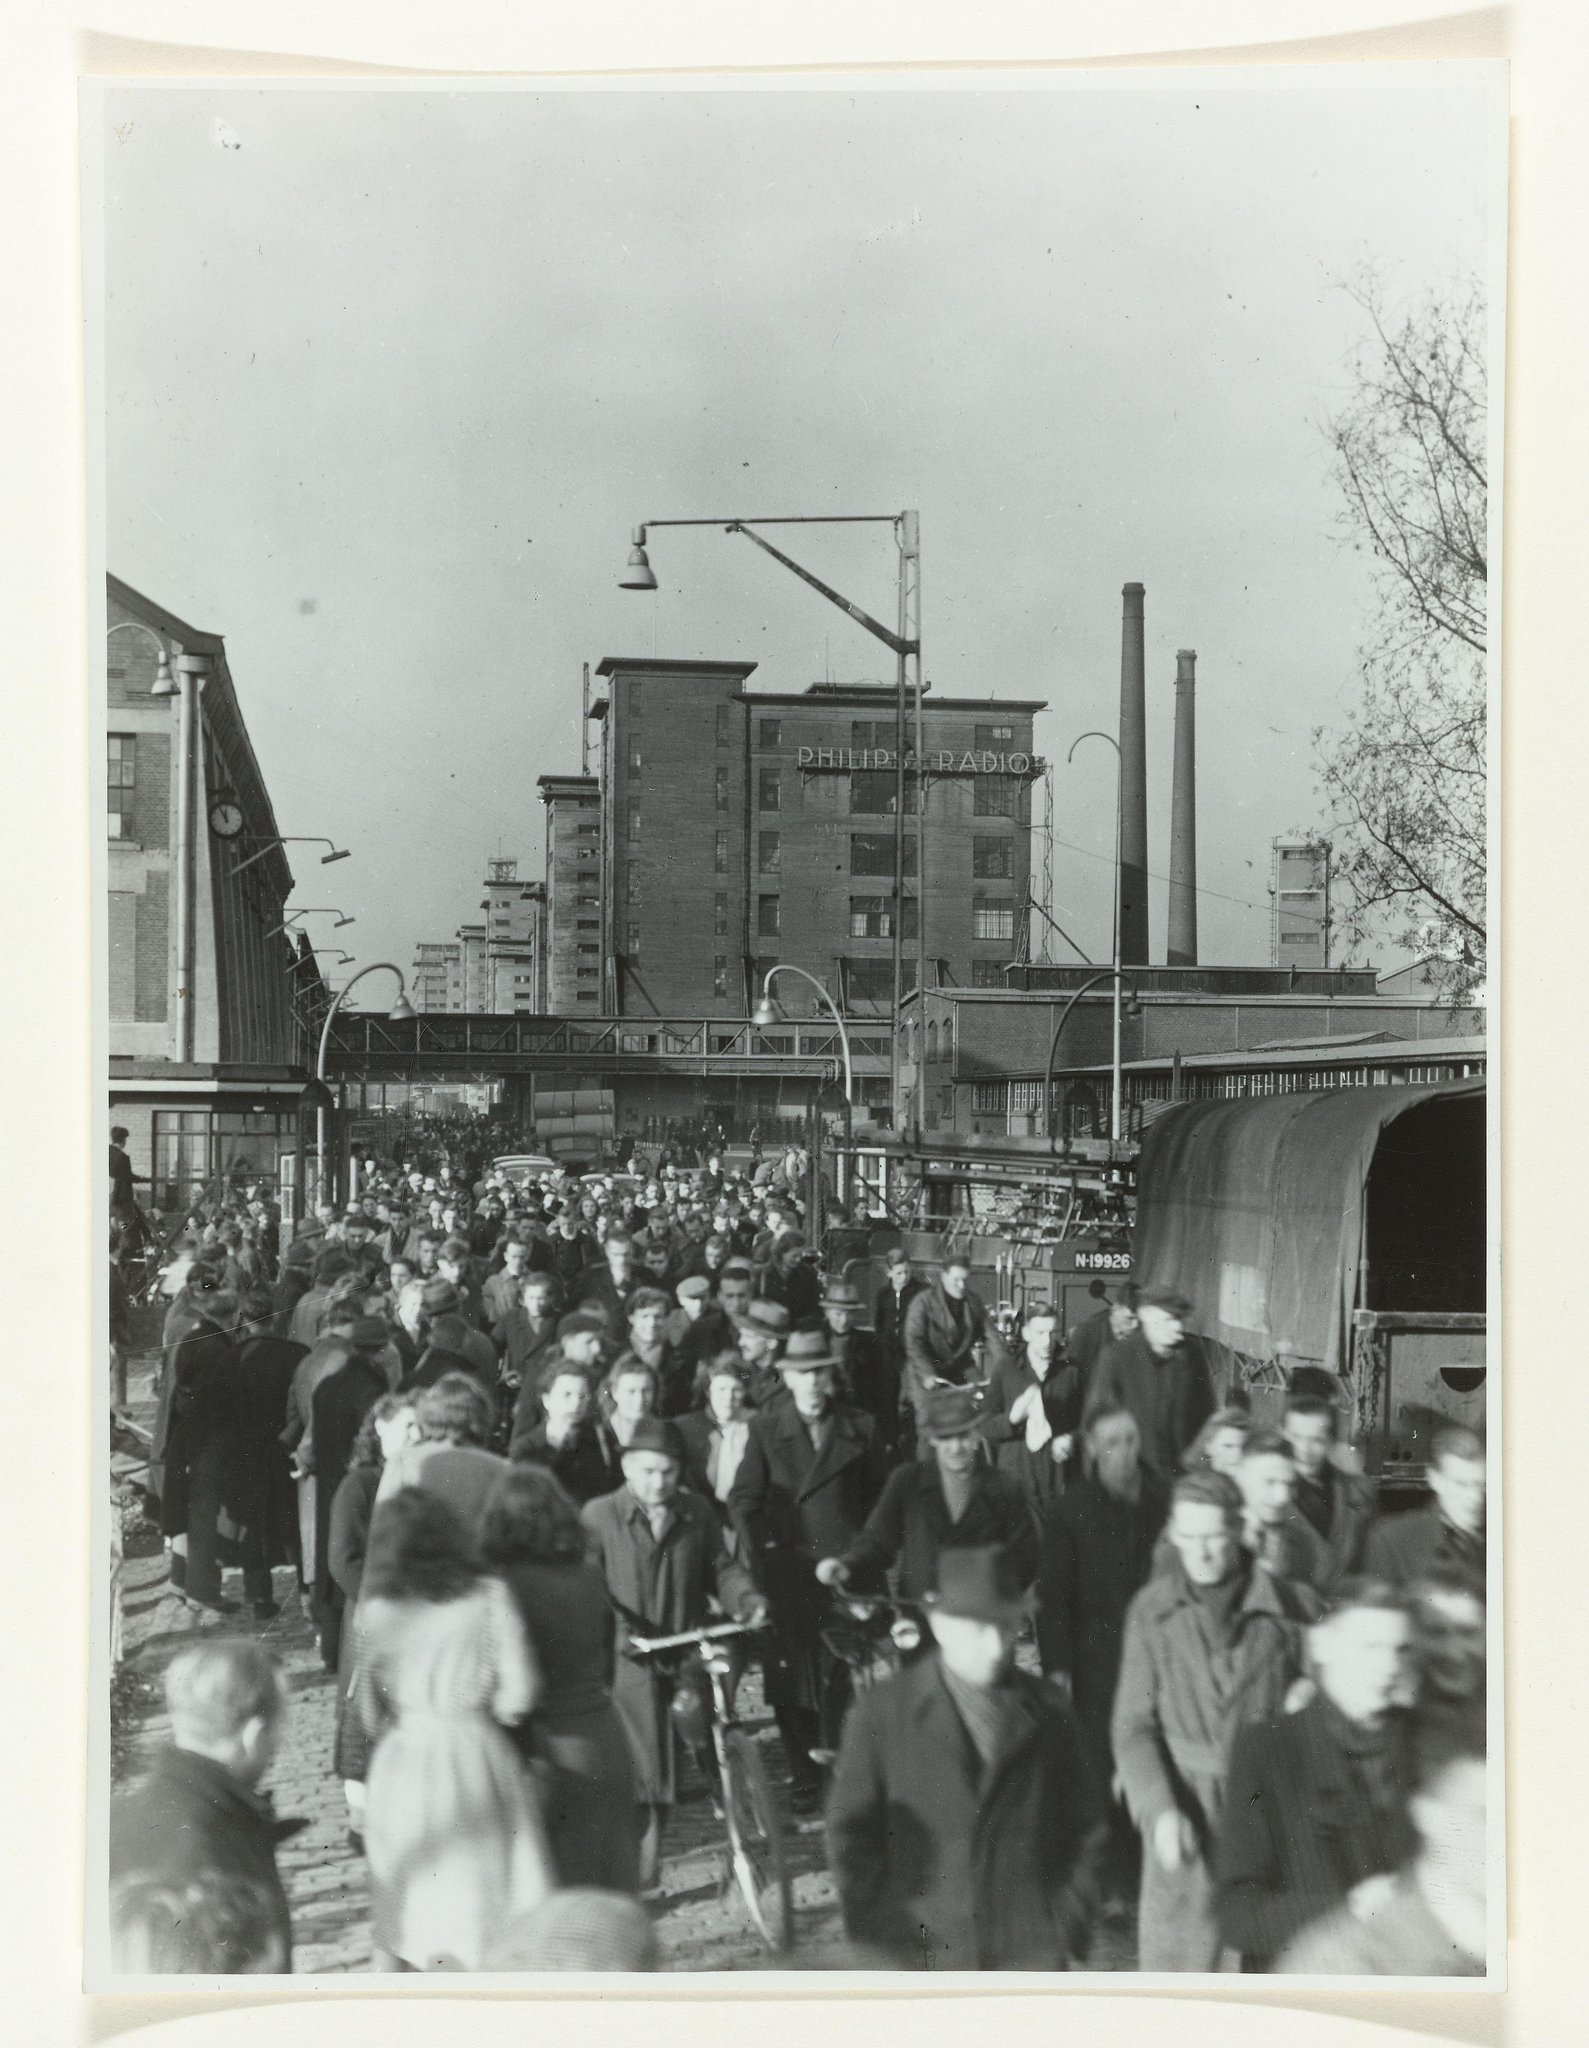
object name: photograph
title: Het uitgaan van de Philips fabriek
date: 1950-1960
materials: photographic support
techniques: gelatin silver print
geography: eindhoven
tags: factory-building, labourers returning home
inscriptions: number: ‘A18444’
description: Stadsgezicht met stroom fietsers. Op één van de gebouwen op de achtergrond staat "Philips Radio"